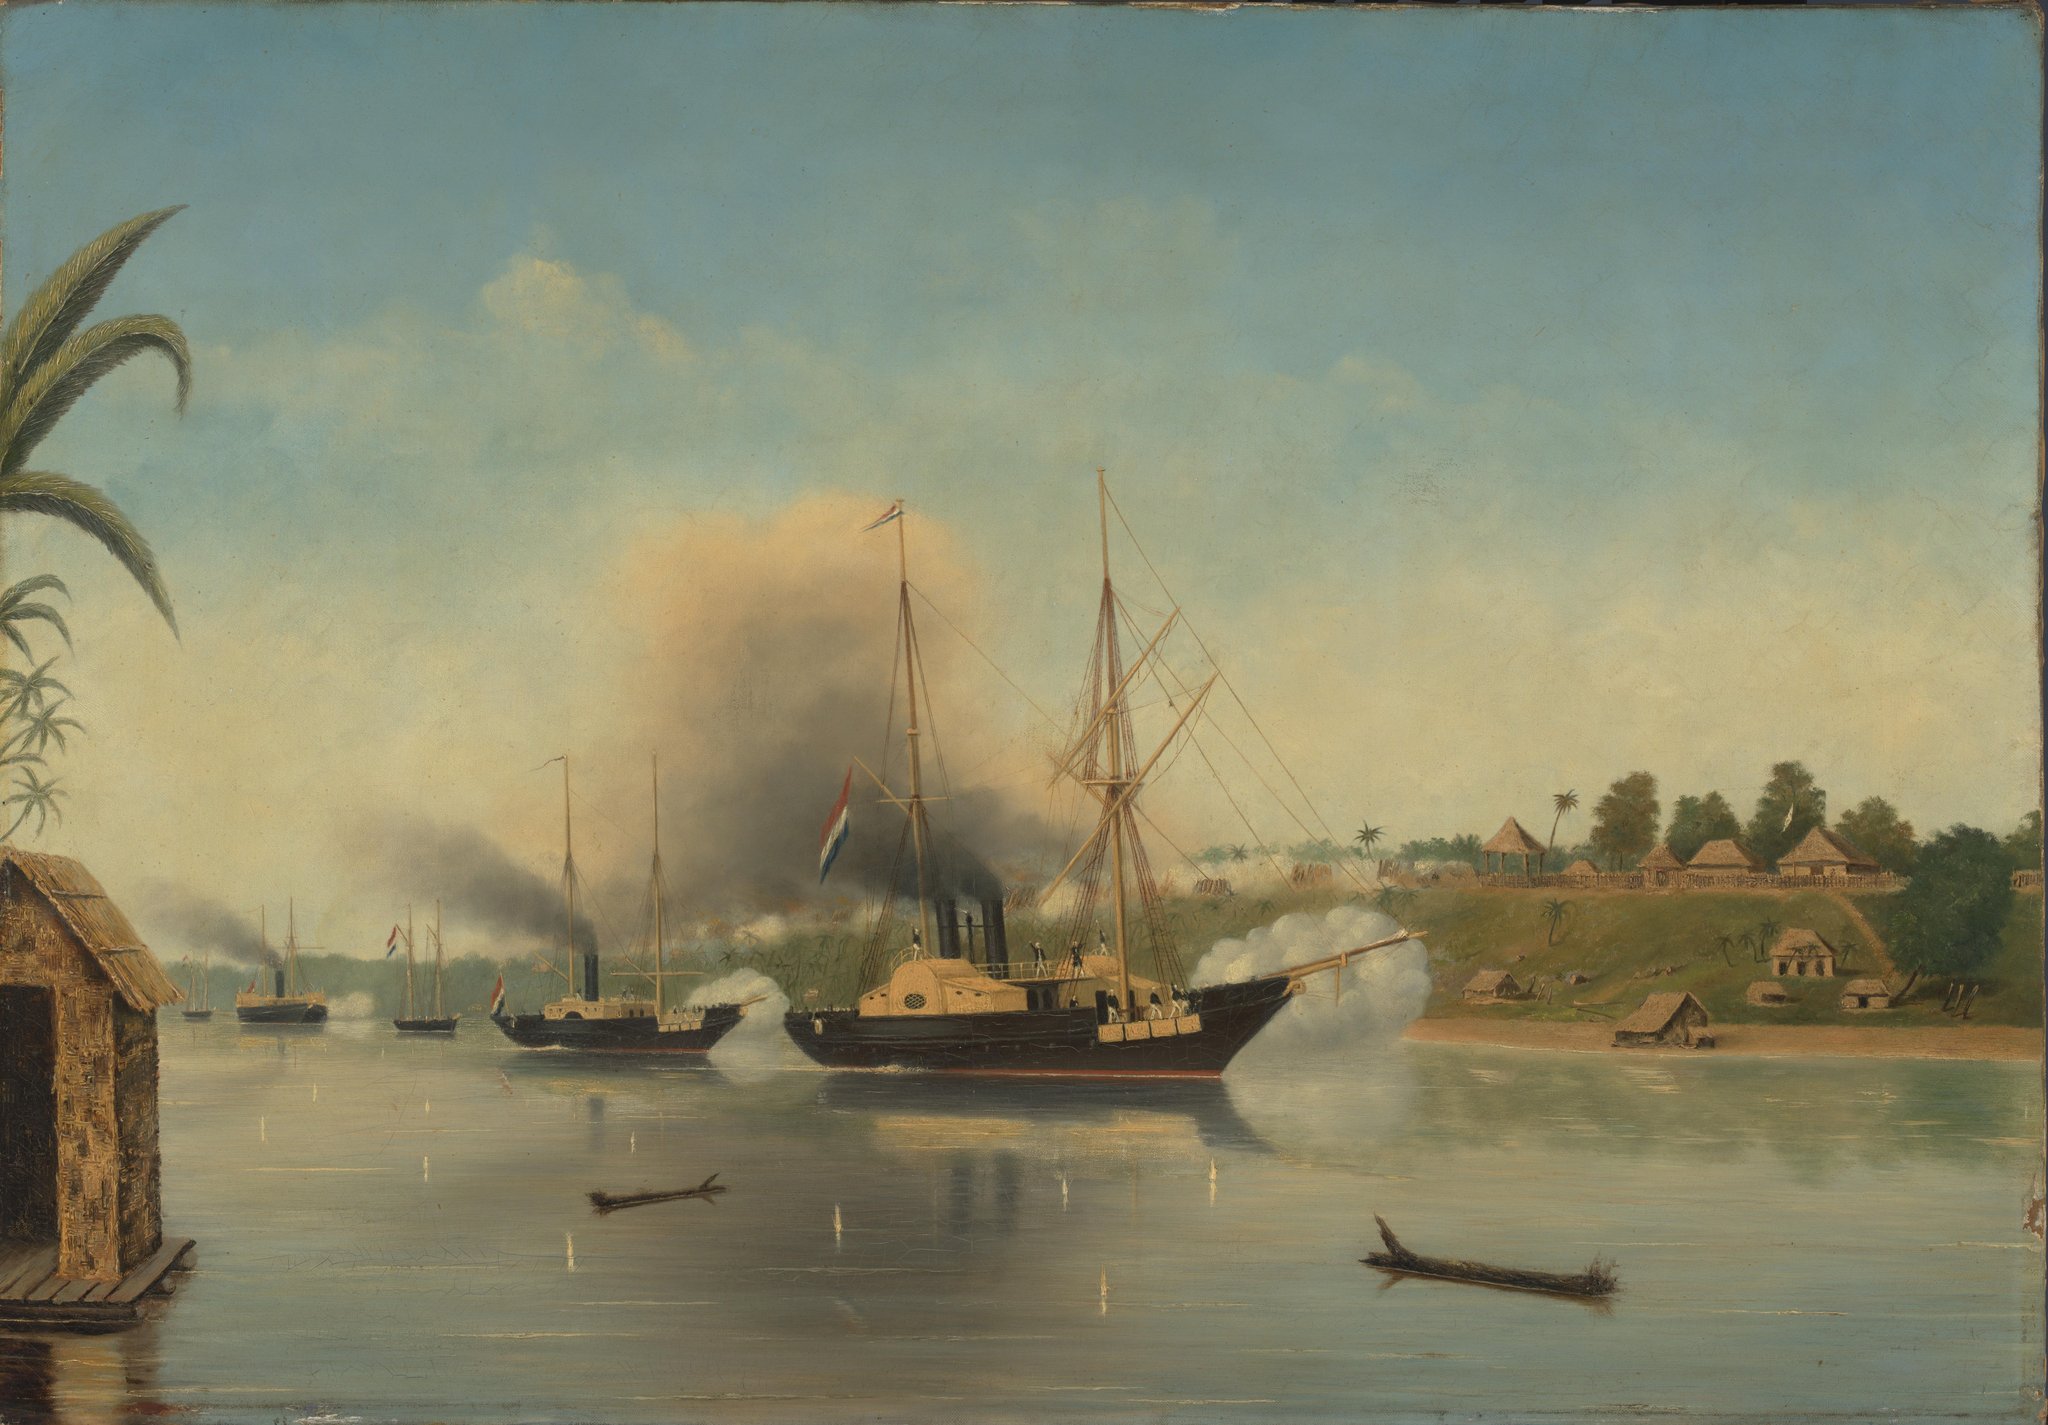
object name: painting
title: De beschieting van de Kraton van de Sultan van Djambi door de gouvernementsmarineschepen 'Celebes', 'Admiraal van Kinsbergen' en 'Onrust' op 8 september 1858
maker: Anonymous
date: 1858-1865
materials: canvas, oil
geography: northern netherlands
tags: (military) attack (+ naval force), steamship, motorship (+ propulsion of vehicle, ship, etc. by steam), sumatra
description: The barrage of the Sultan of Djambi's kraton on Sumatra by three Dutch paddlesteamers, 5 September 1858. Following the refusal by the new sultan of Djambi, on eastern Sumatra, to recognise Dutch sovereignty in the East Indies, a military campaign was organised against him in 1858. The sultan's throne was declared forfeit and his kraton (palace) was captured. He fled inland. His successor agreed that in future Djambi would remain part of the Dutch East Indies and subject to colonial authority. The anonymous artist portrayed the paddlesteamers Celebes, Admiral van Kinsbergen and Onrust bombarding the kraton from Djambi river.